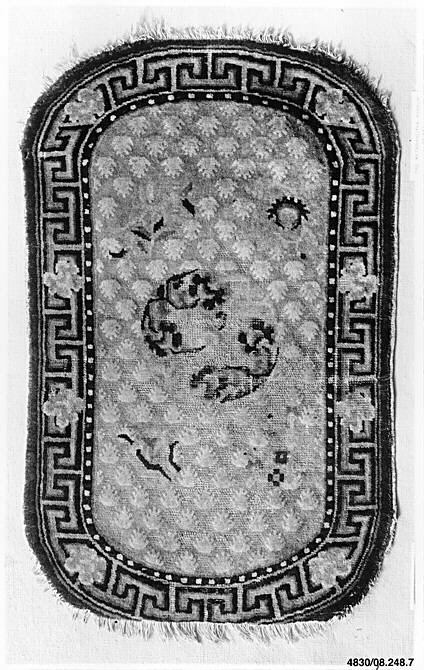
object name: rug or cushion cover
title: Oval Rug Or Cushion Cover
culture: chinese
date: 1701-1800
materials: cotton, wool